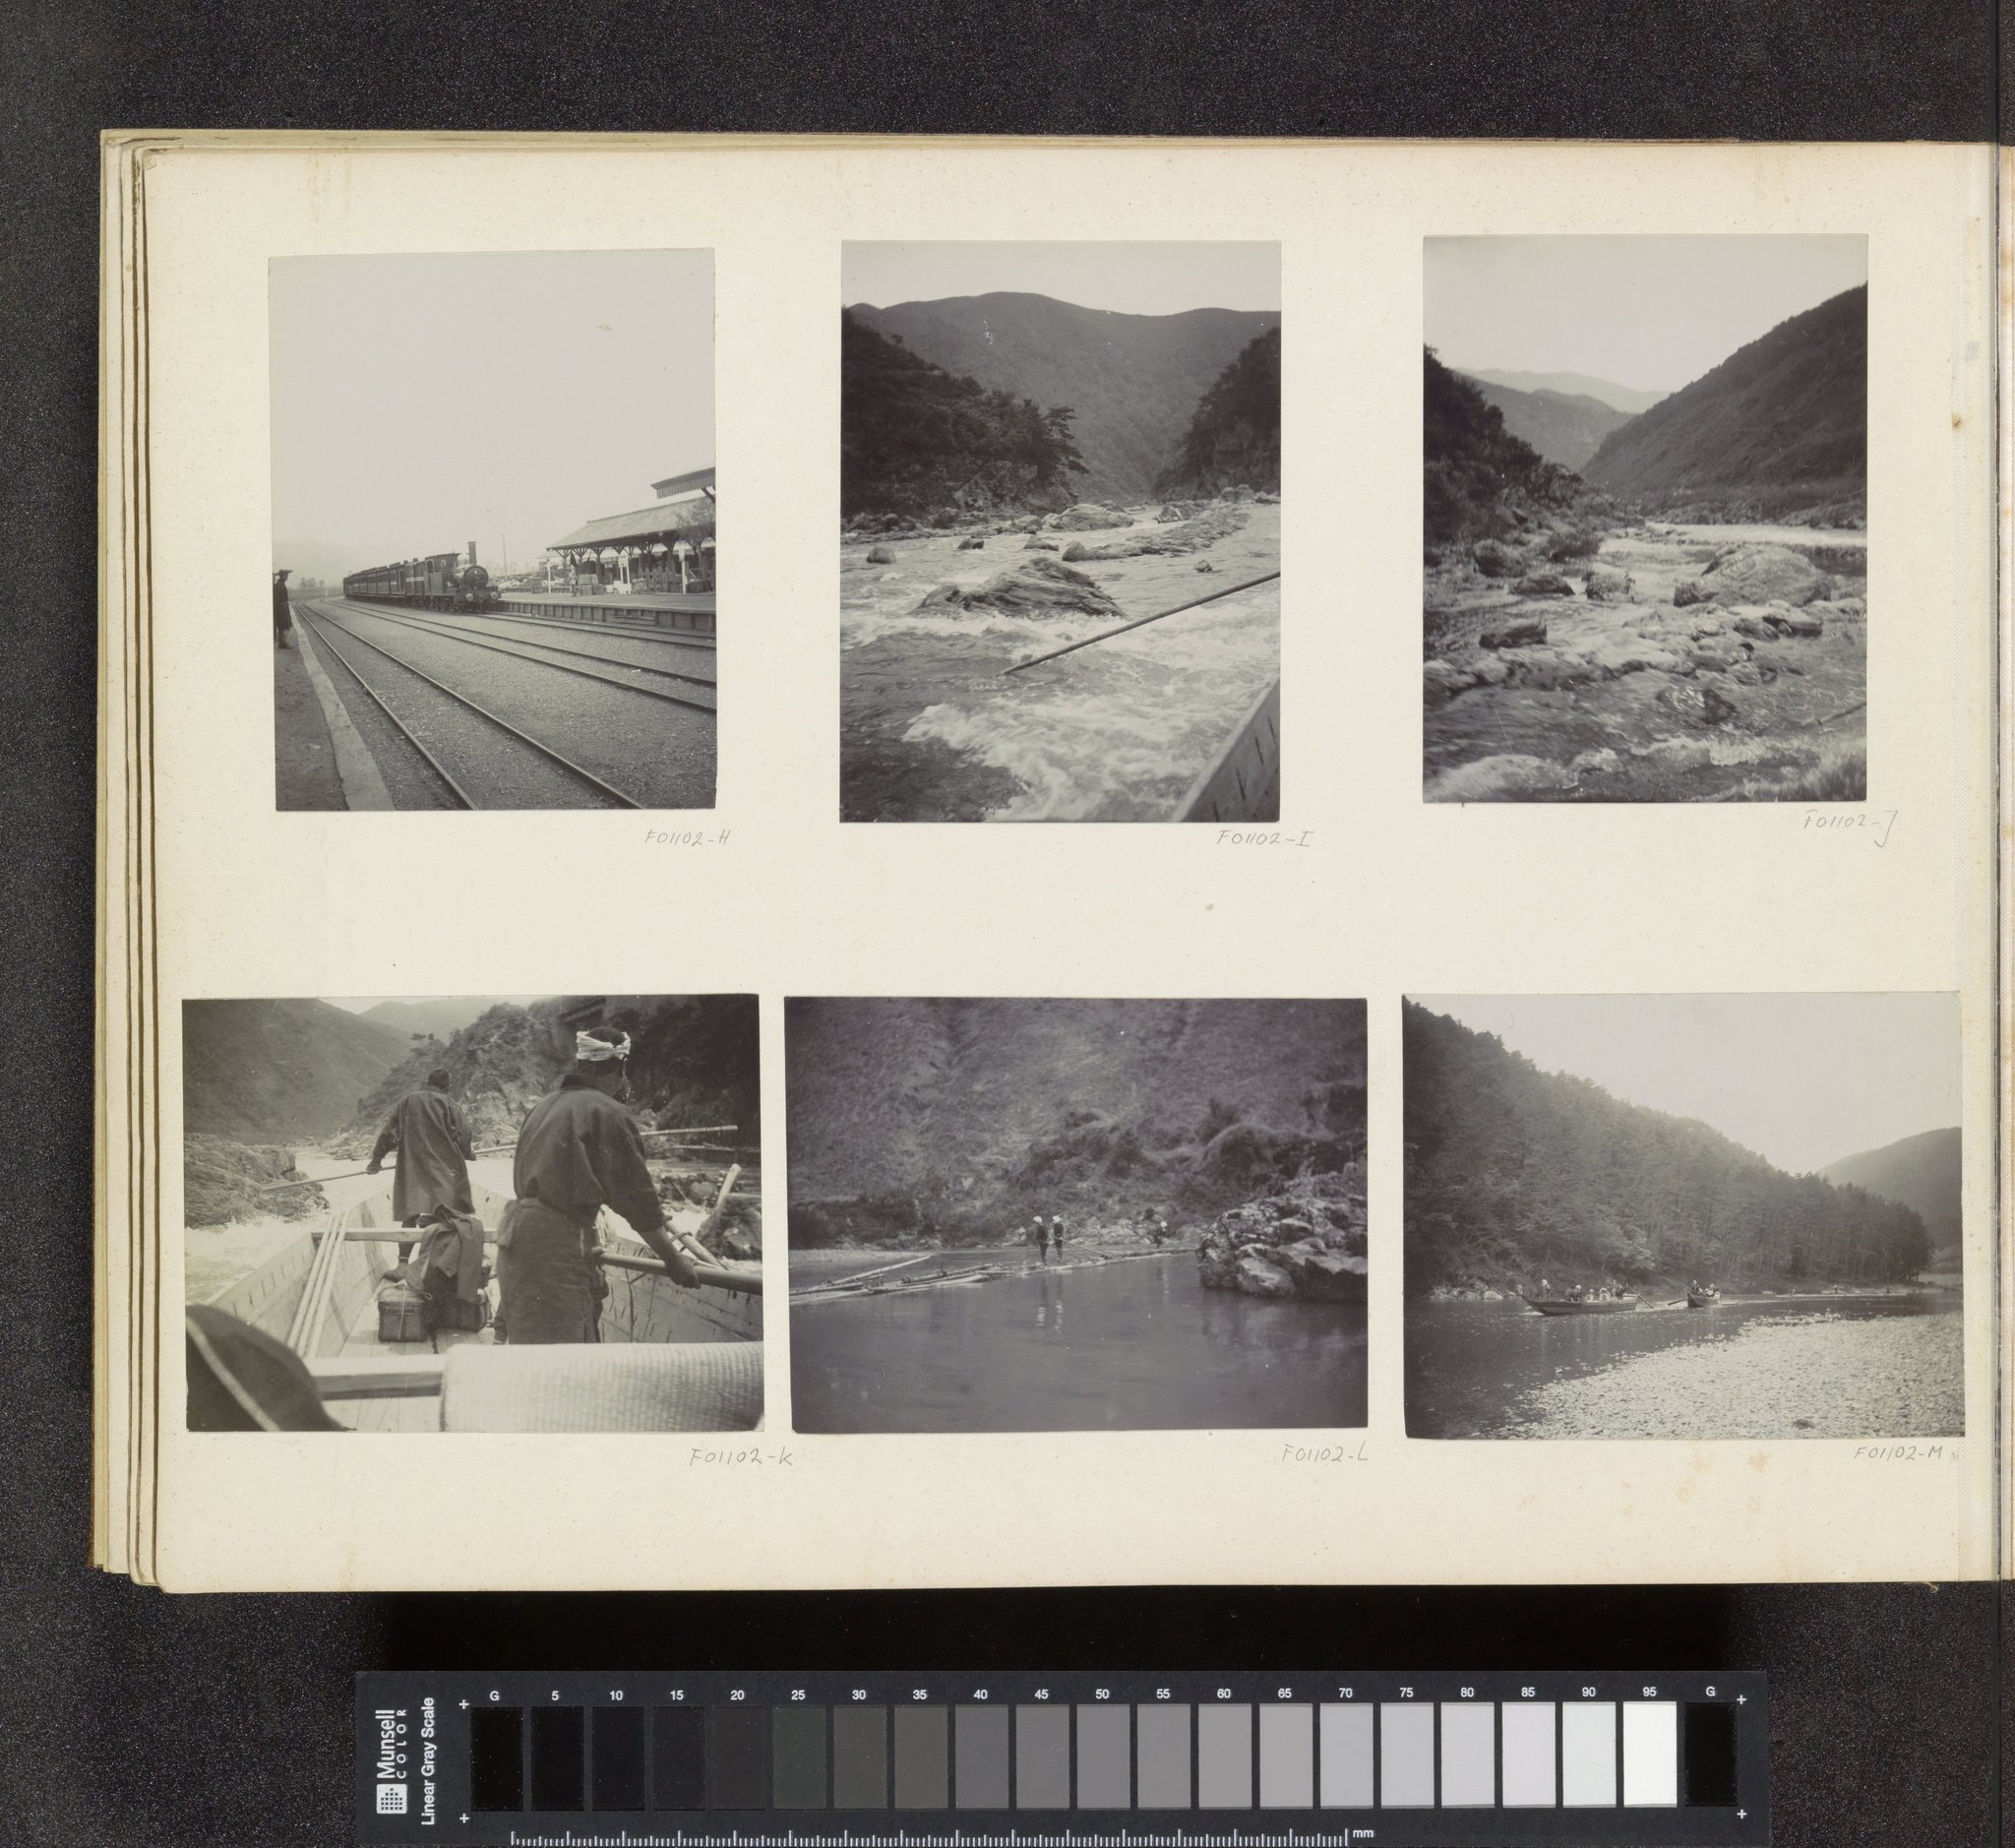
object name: album leaf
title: Mannen op een vlot in een rivier in Japan, mogelijk vissers met aalscholvers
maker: Anonymous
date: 1900-1940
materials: cardboard, paper, photographic support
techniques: gelatin silver print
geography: japan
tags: rowing-boat, canoe, etc., fisherman, japan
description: Onderdeel van Reisalbum met foto's van bezienswaardigheden in Japan.